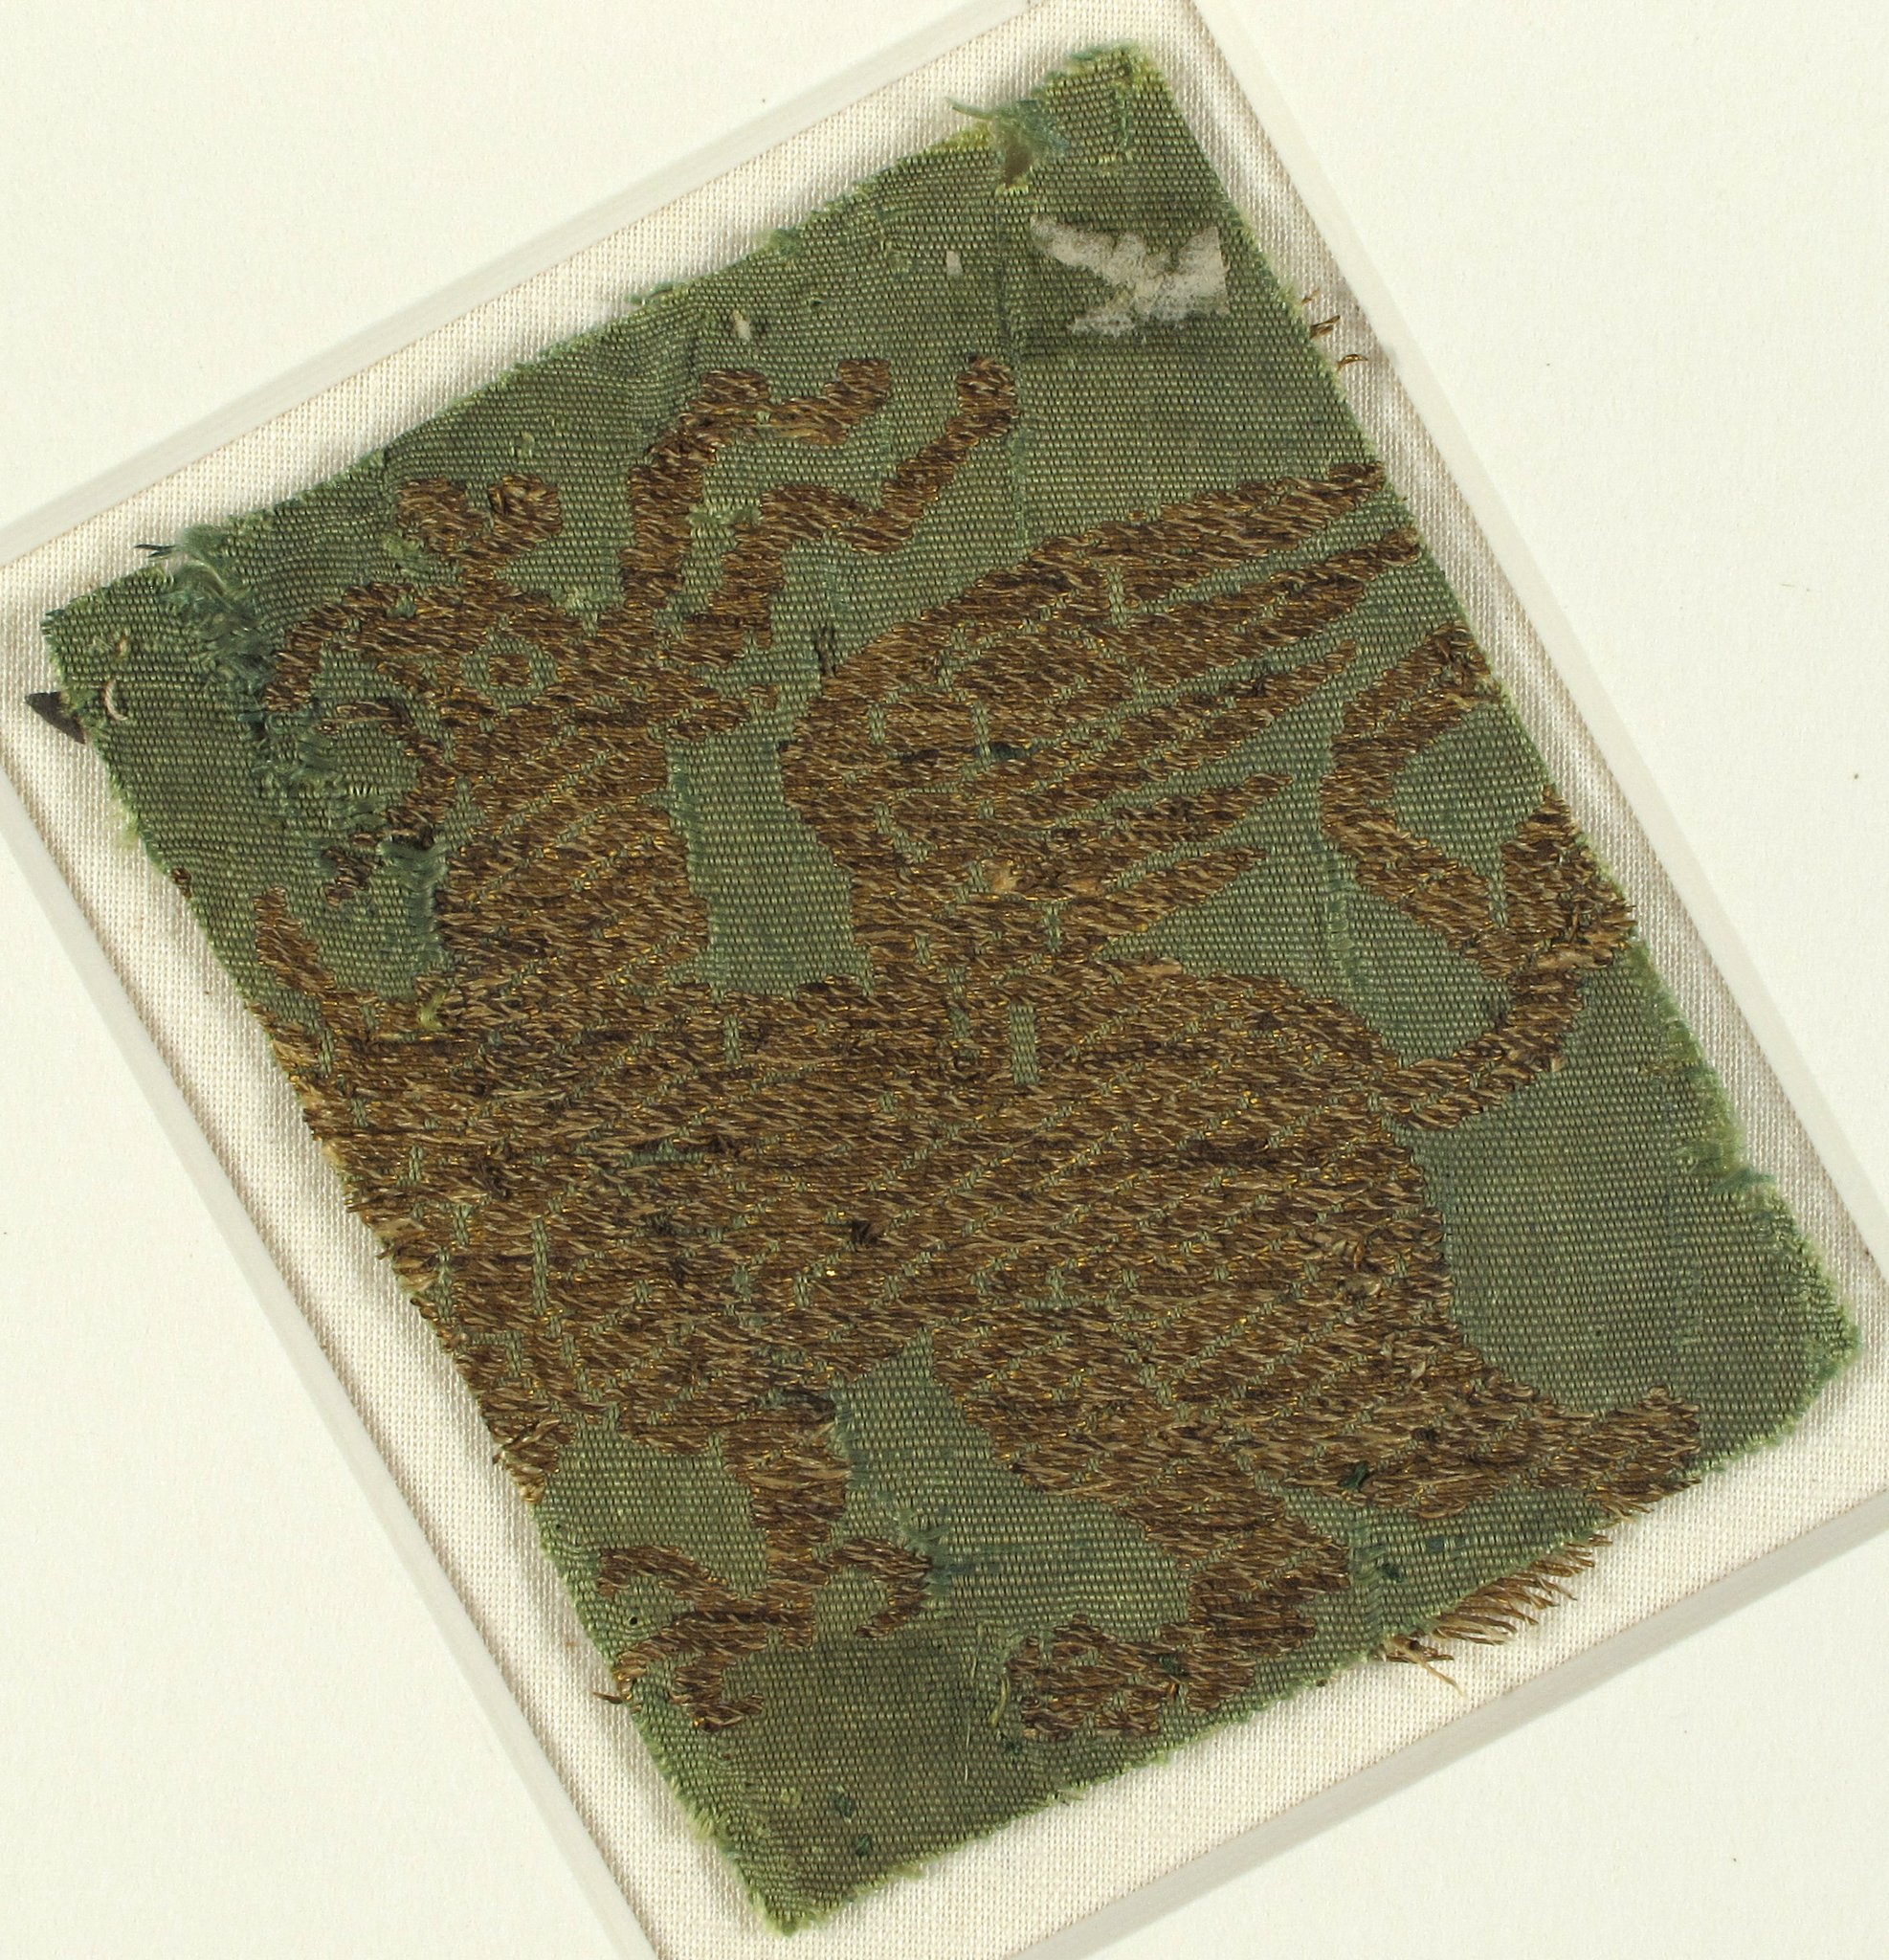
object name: textile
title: Textile with Griffin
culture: italian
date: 1301-1400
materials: textile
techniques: weave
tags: griffins